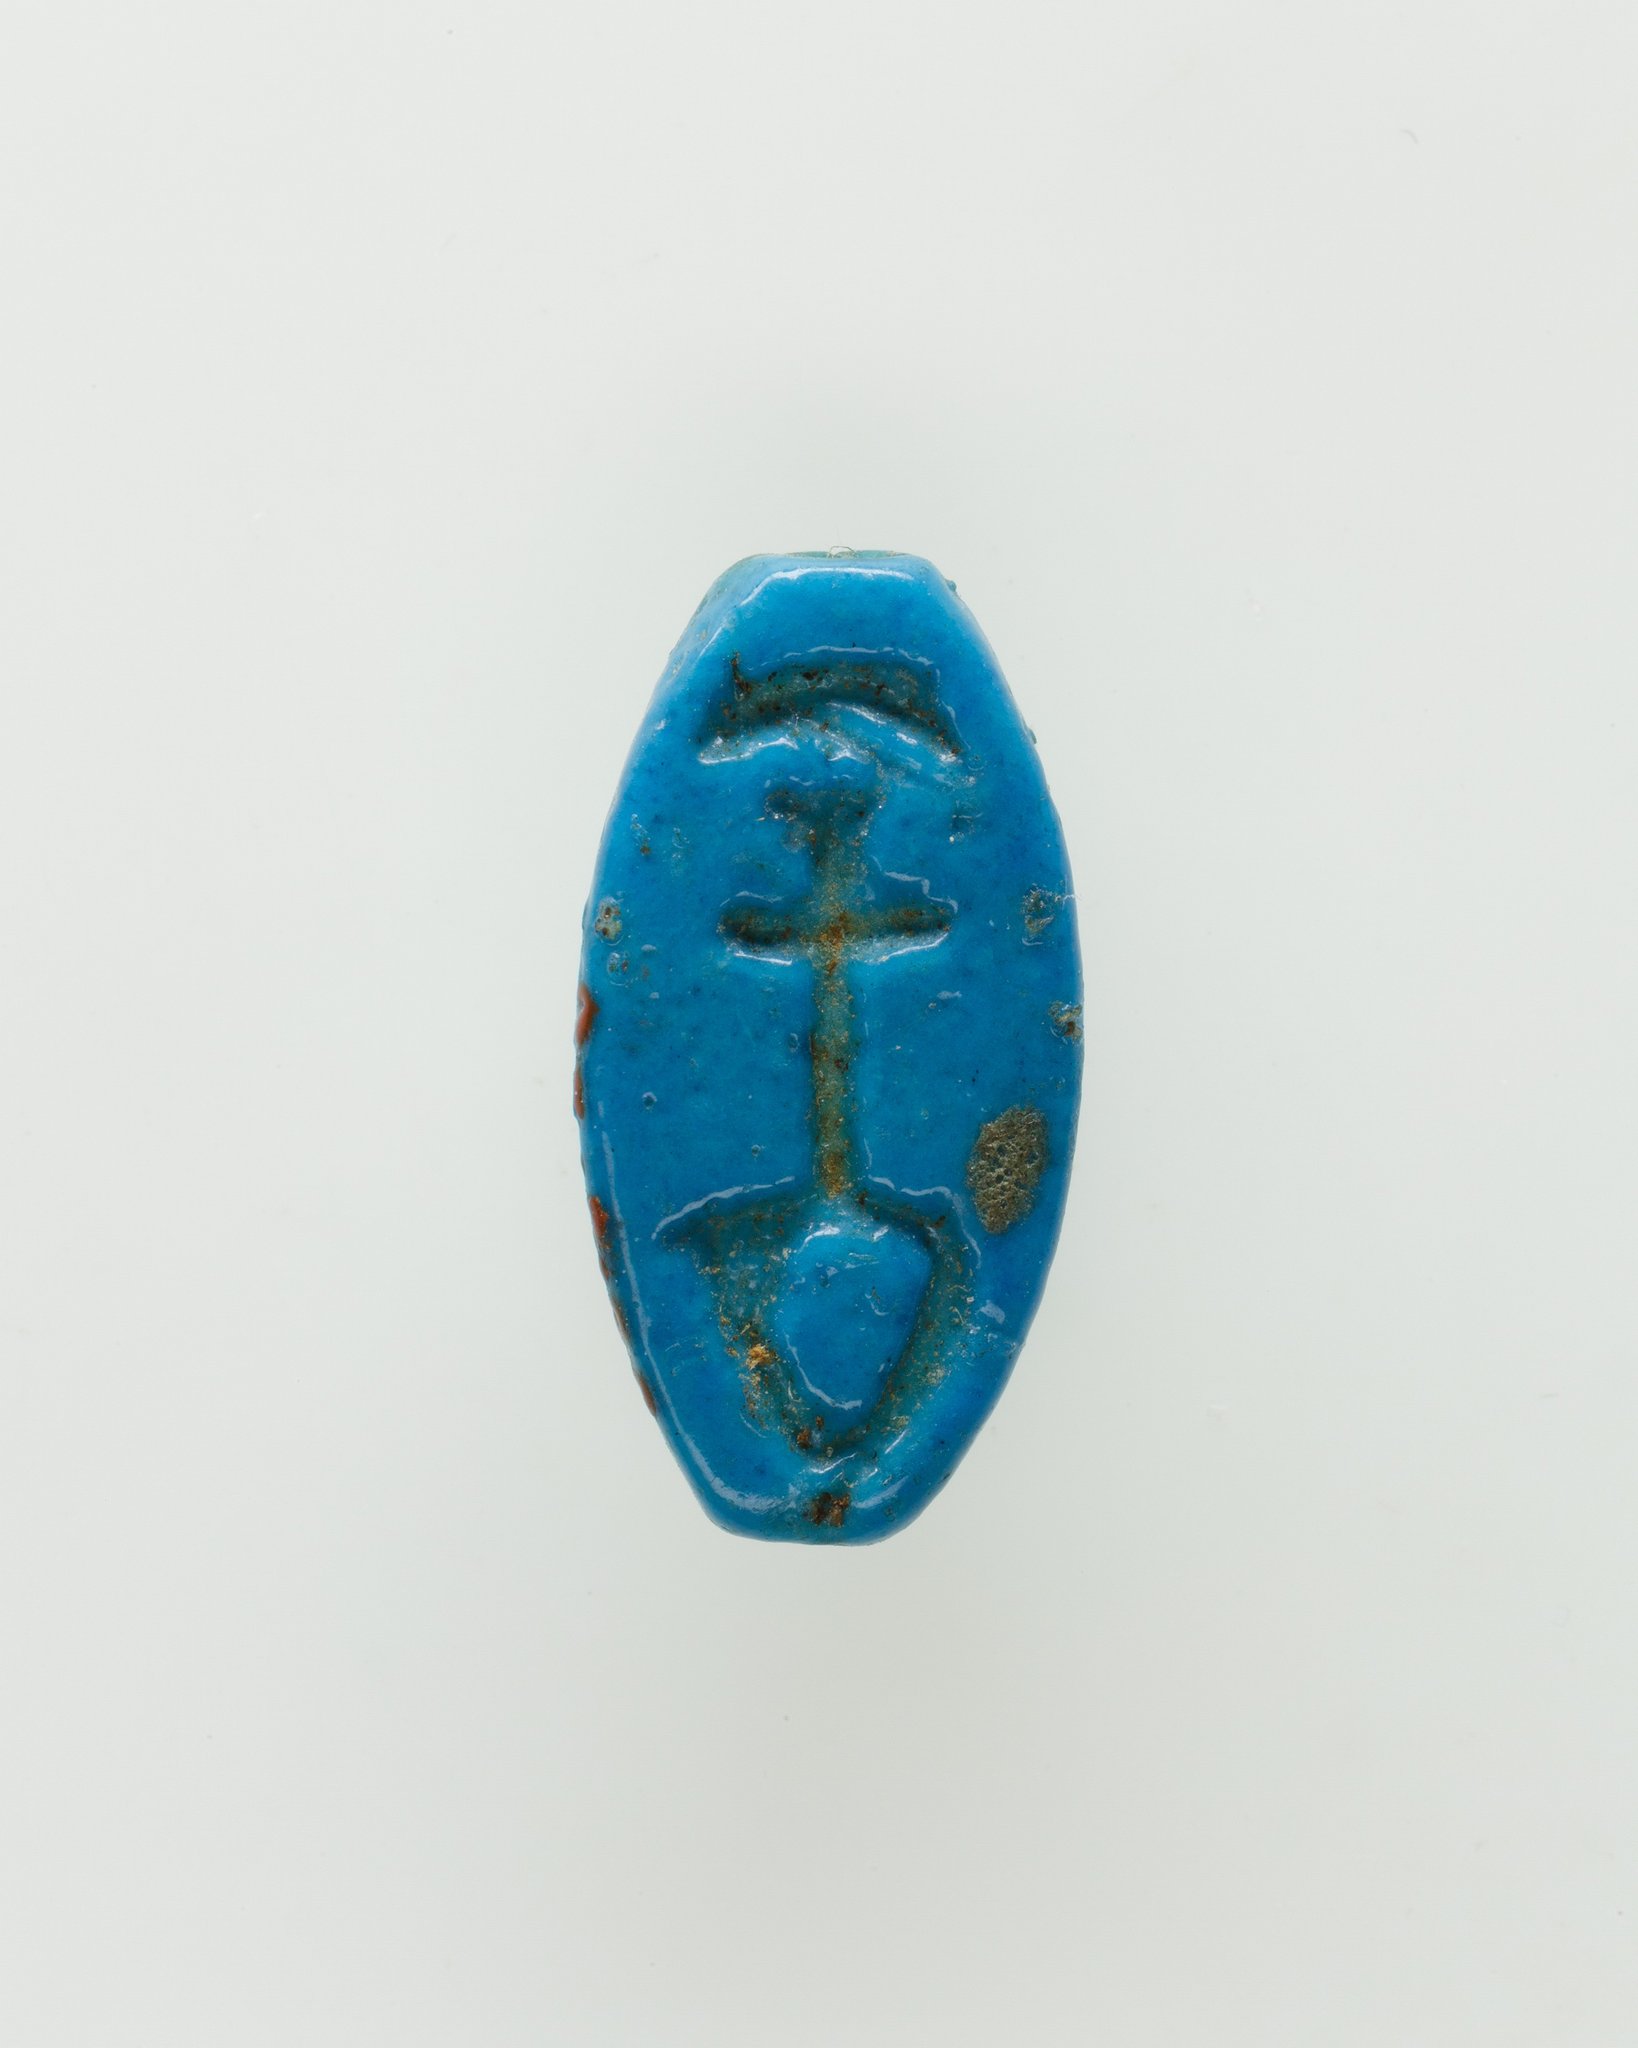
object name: cowroid, nefer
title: Cowroid Inscribed with a Nefer Hieroglyph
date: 1492-1473 BCE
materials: faience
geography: egypt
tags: hieroglyphs